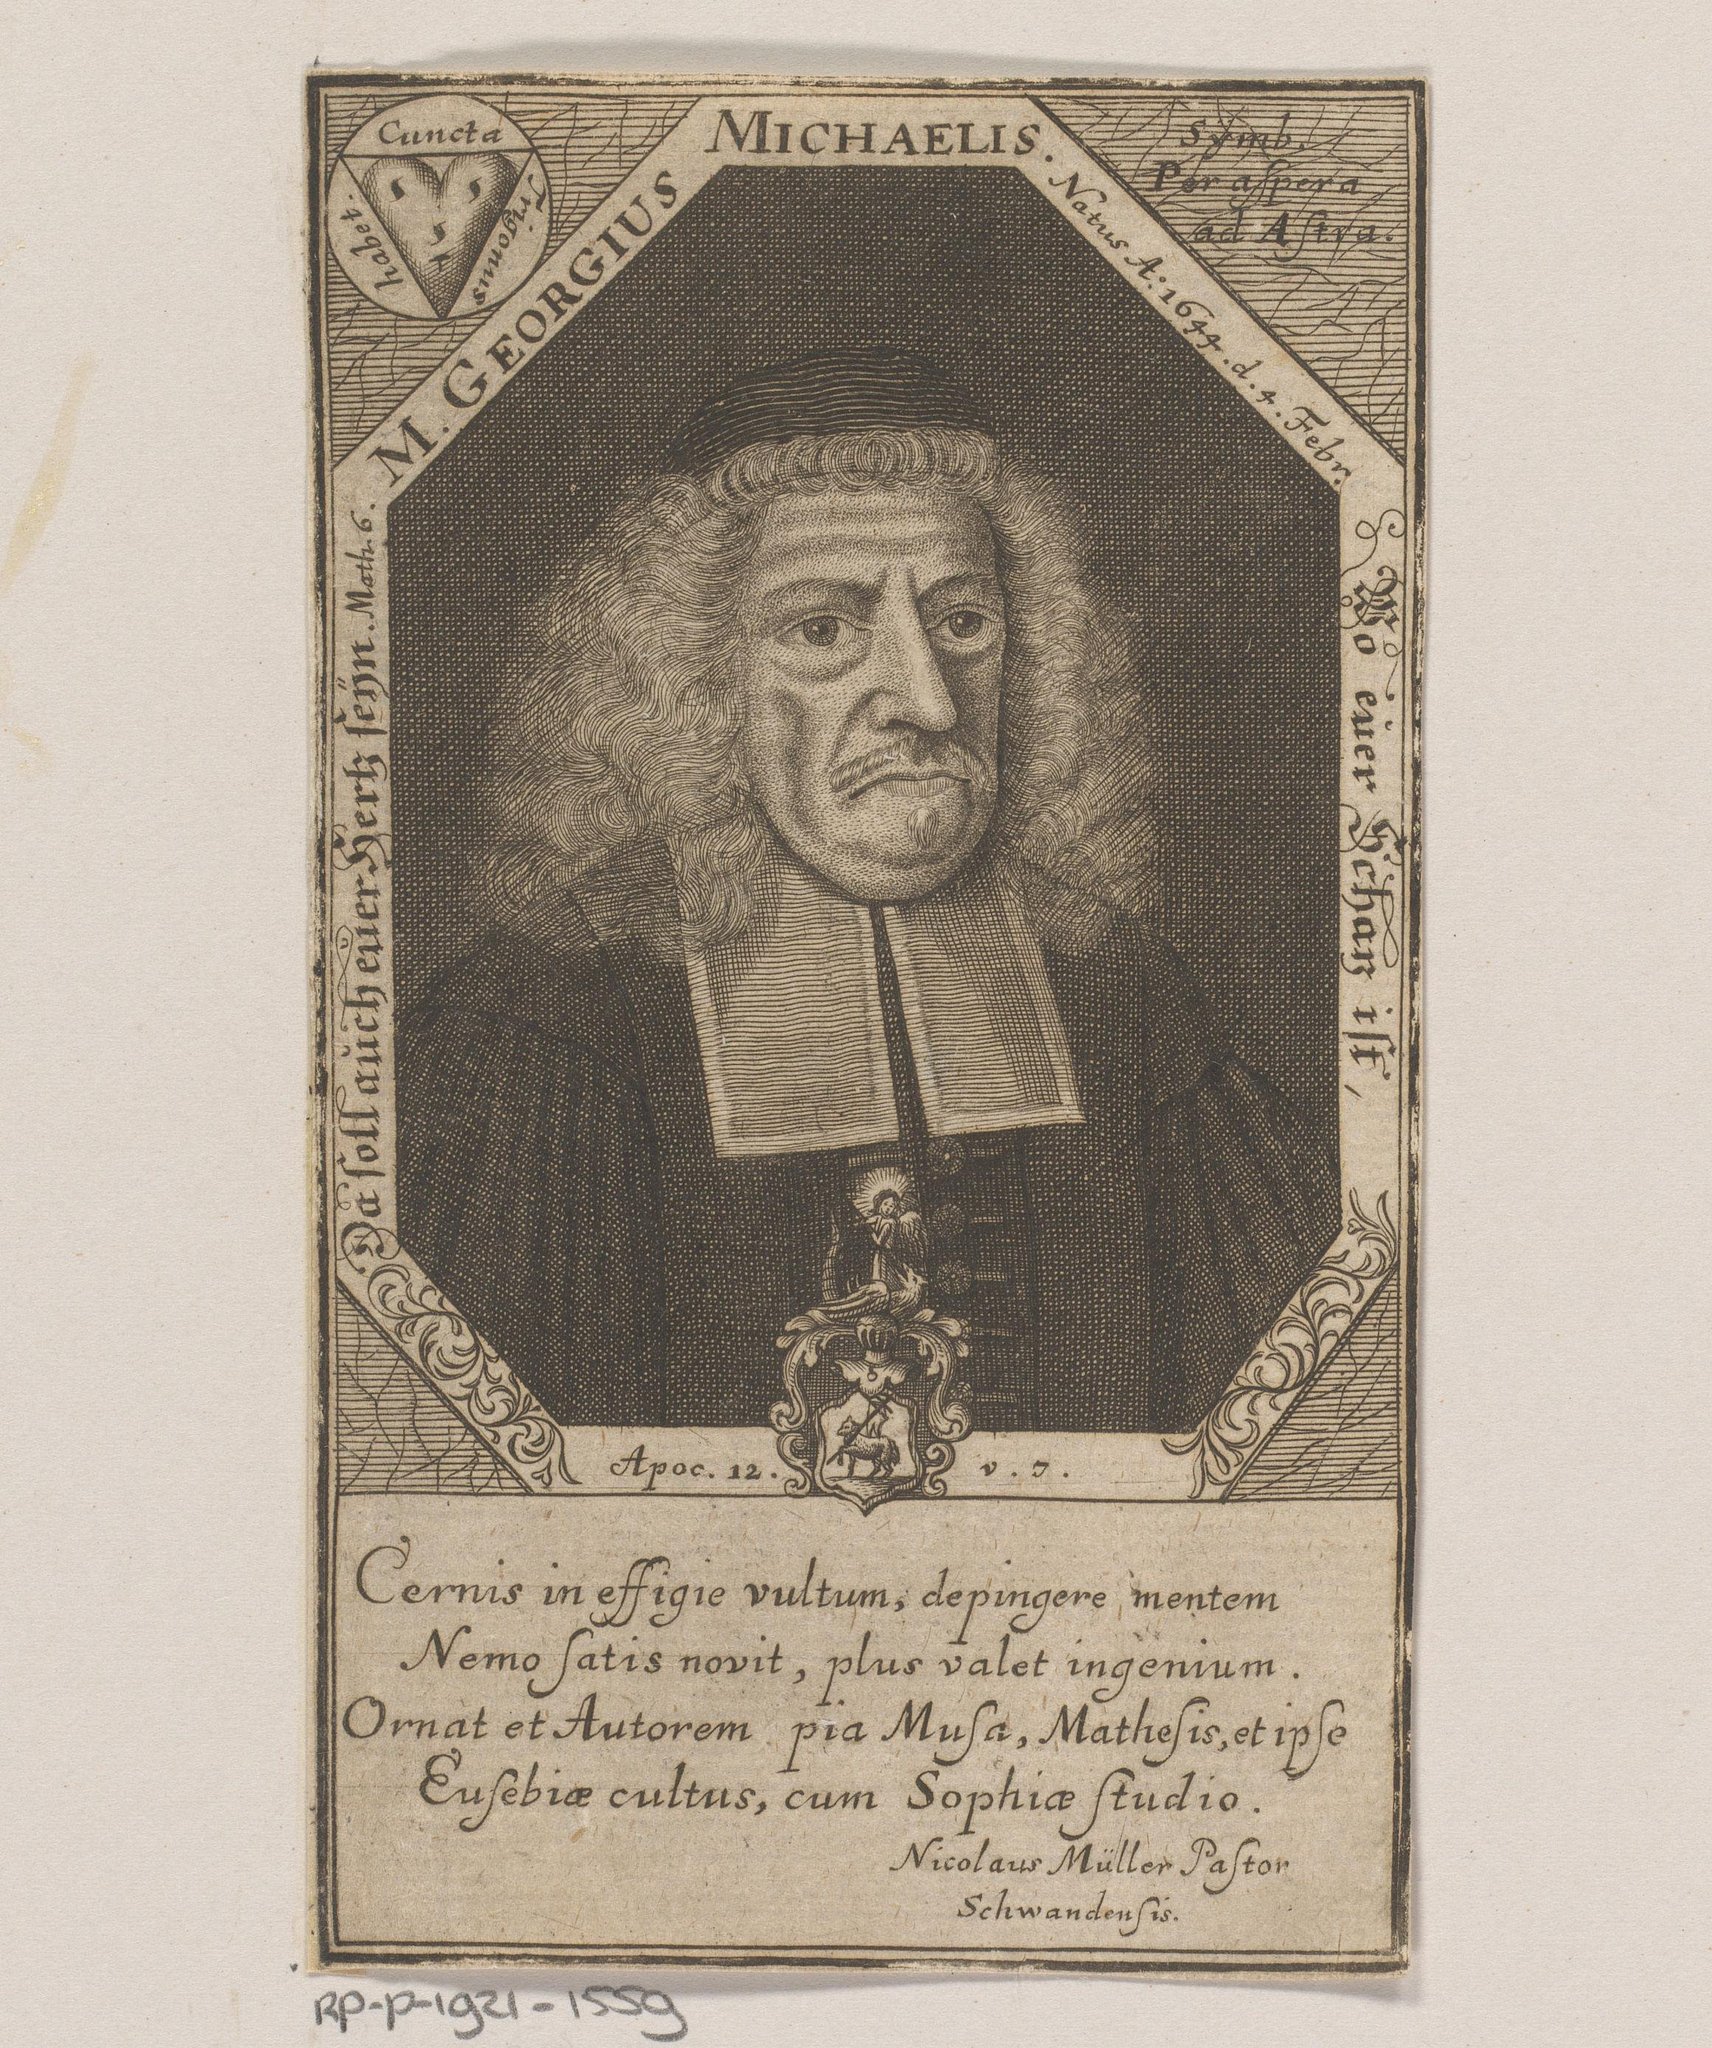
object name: book illustration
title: Portret van Georg Michaelis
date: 1711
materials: paper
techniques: engraving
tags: theologian, historical persons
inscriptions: collector's mark: Lugt 2233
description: Prent waarschijnlijk uit: Michaelis, Georg. Concordanz. S.l.s.n., 1711.